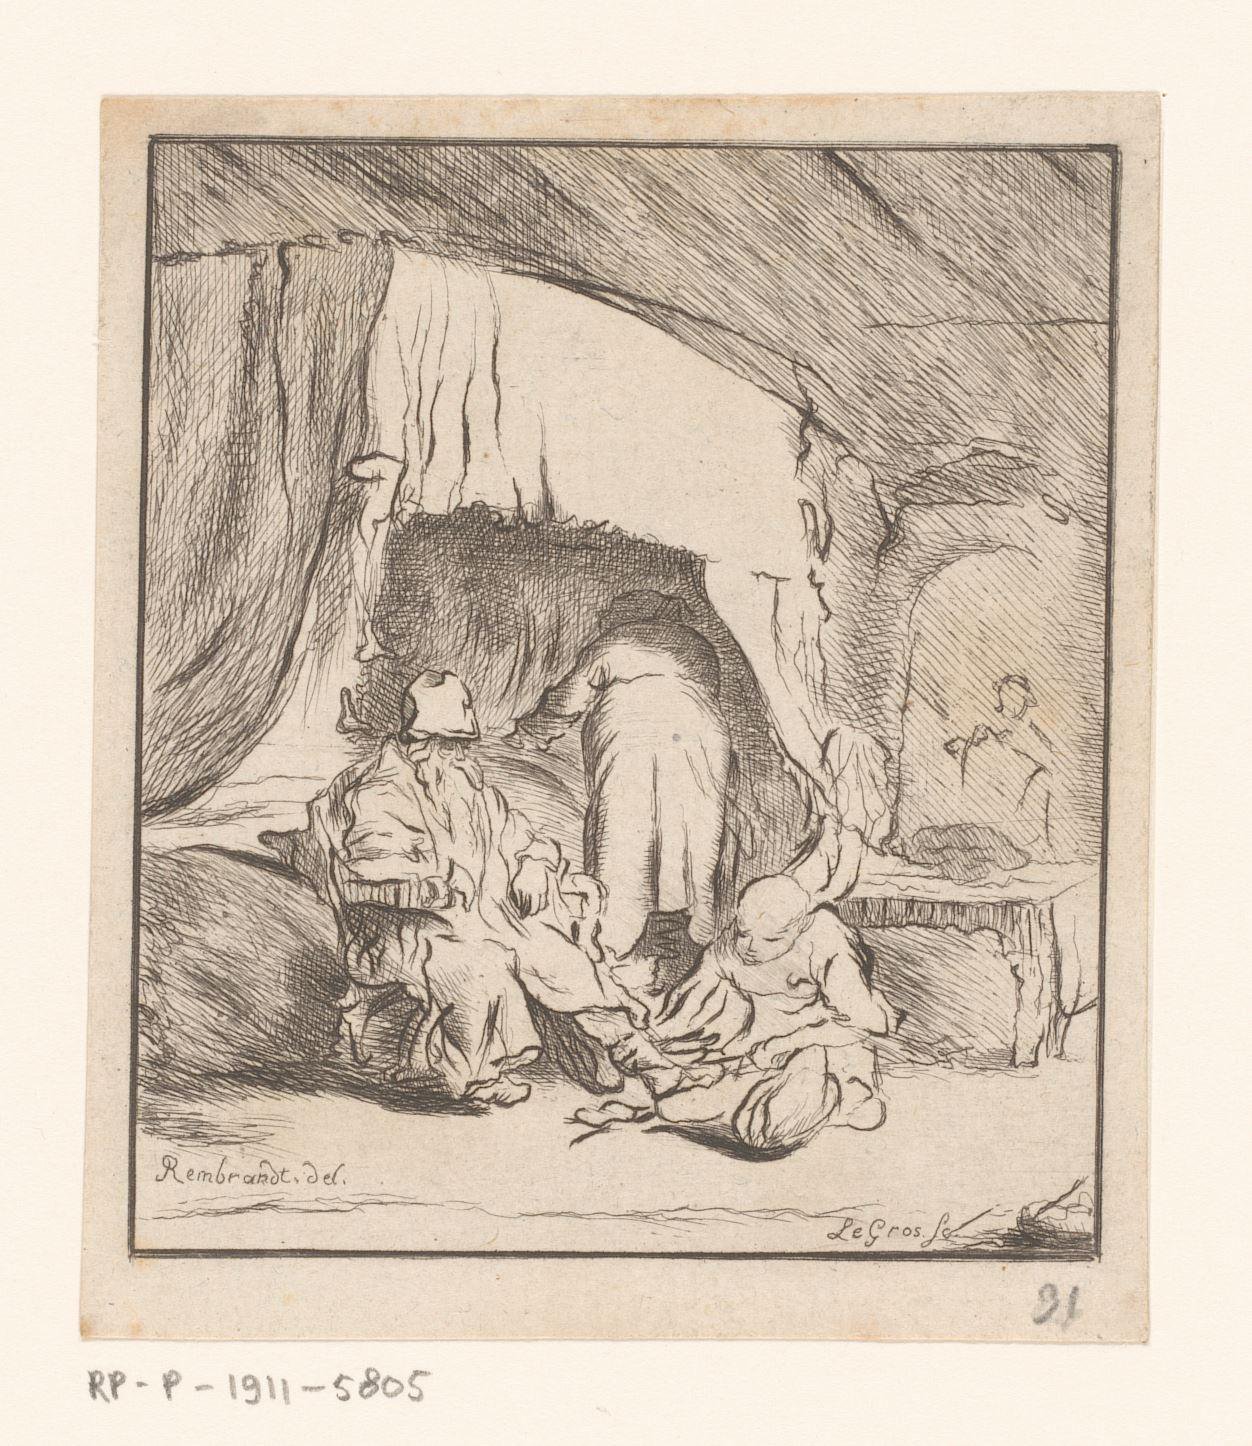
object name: print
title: Interieur met een oude man op een stoel voor een bed met drie andere figuren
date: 1764-1834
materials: paper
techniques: engraving, etching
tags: old man, bed, dressing and undressing, bedroom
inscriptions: collector's mark: Lugt 2228, collector's mark: Lugt 1485